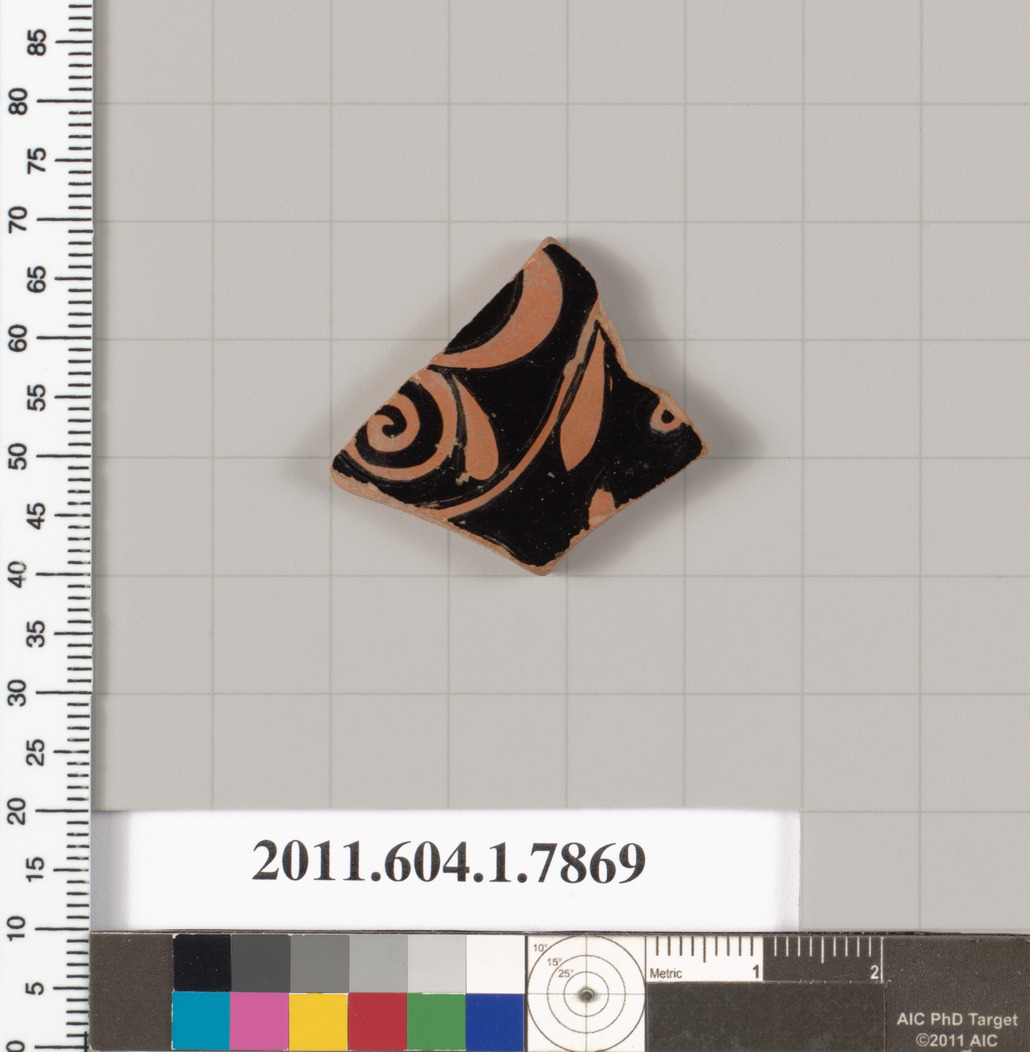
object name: kylix fragment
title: Terracotta fragment of a kylix (drinking cup)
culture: greek, attic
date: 440-420 BCE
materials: terracotta